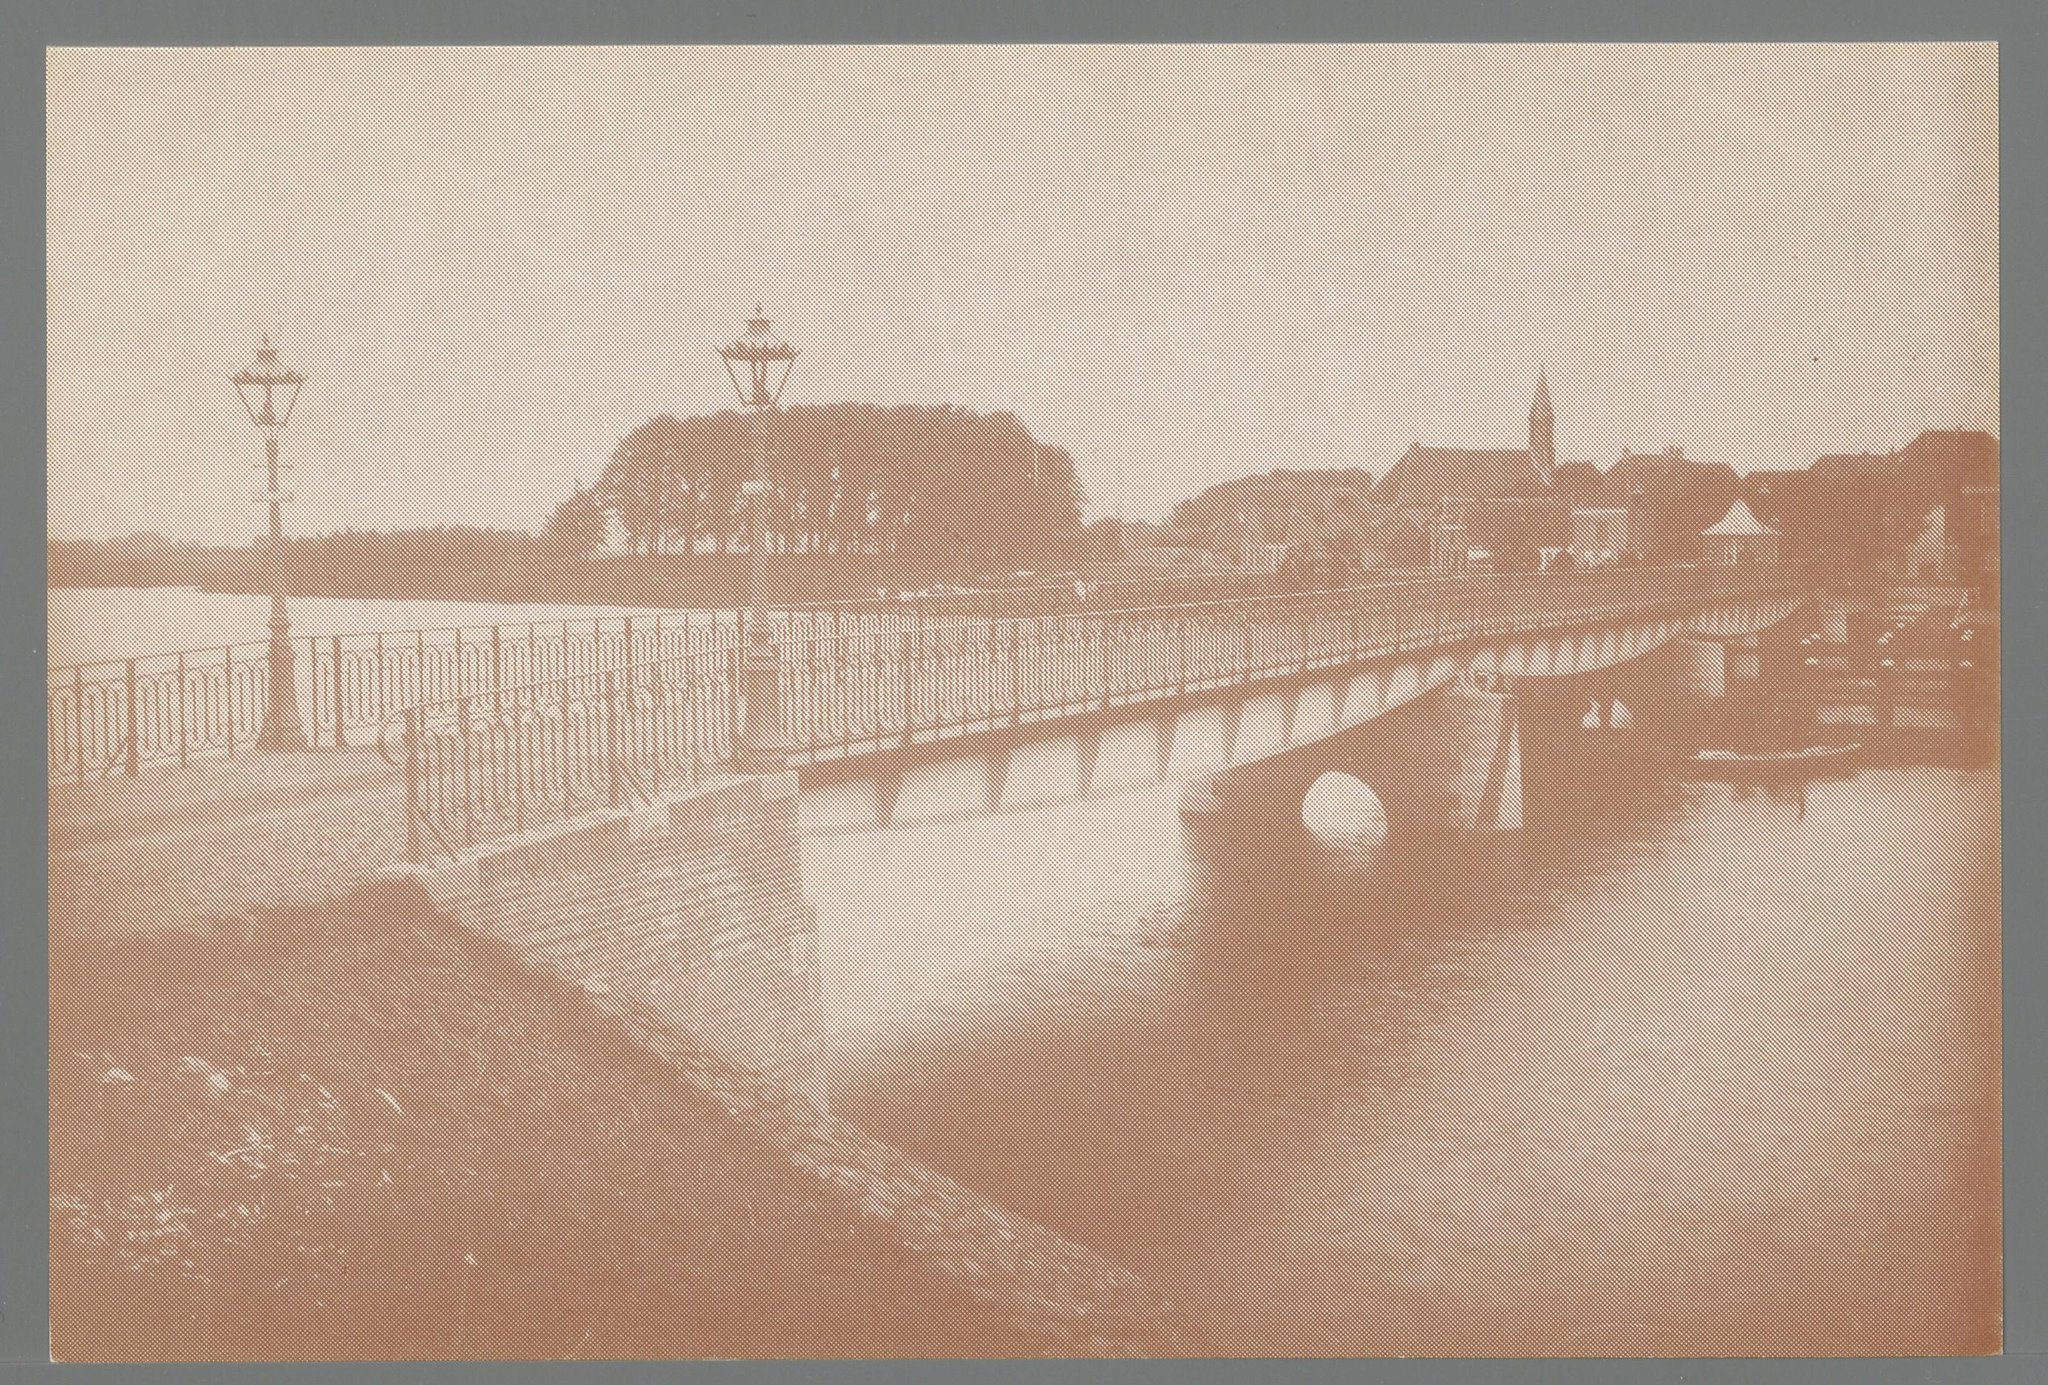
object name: ansichtkaart, prentbriefkaart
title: De brug over het Zwartewater te Hasselt, 1896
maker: Anonymous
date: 1958-2021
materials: cardboard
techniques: autotype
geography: hasselt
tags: river, church (exterior), bridge